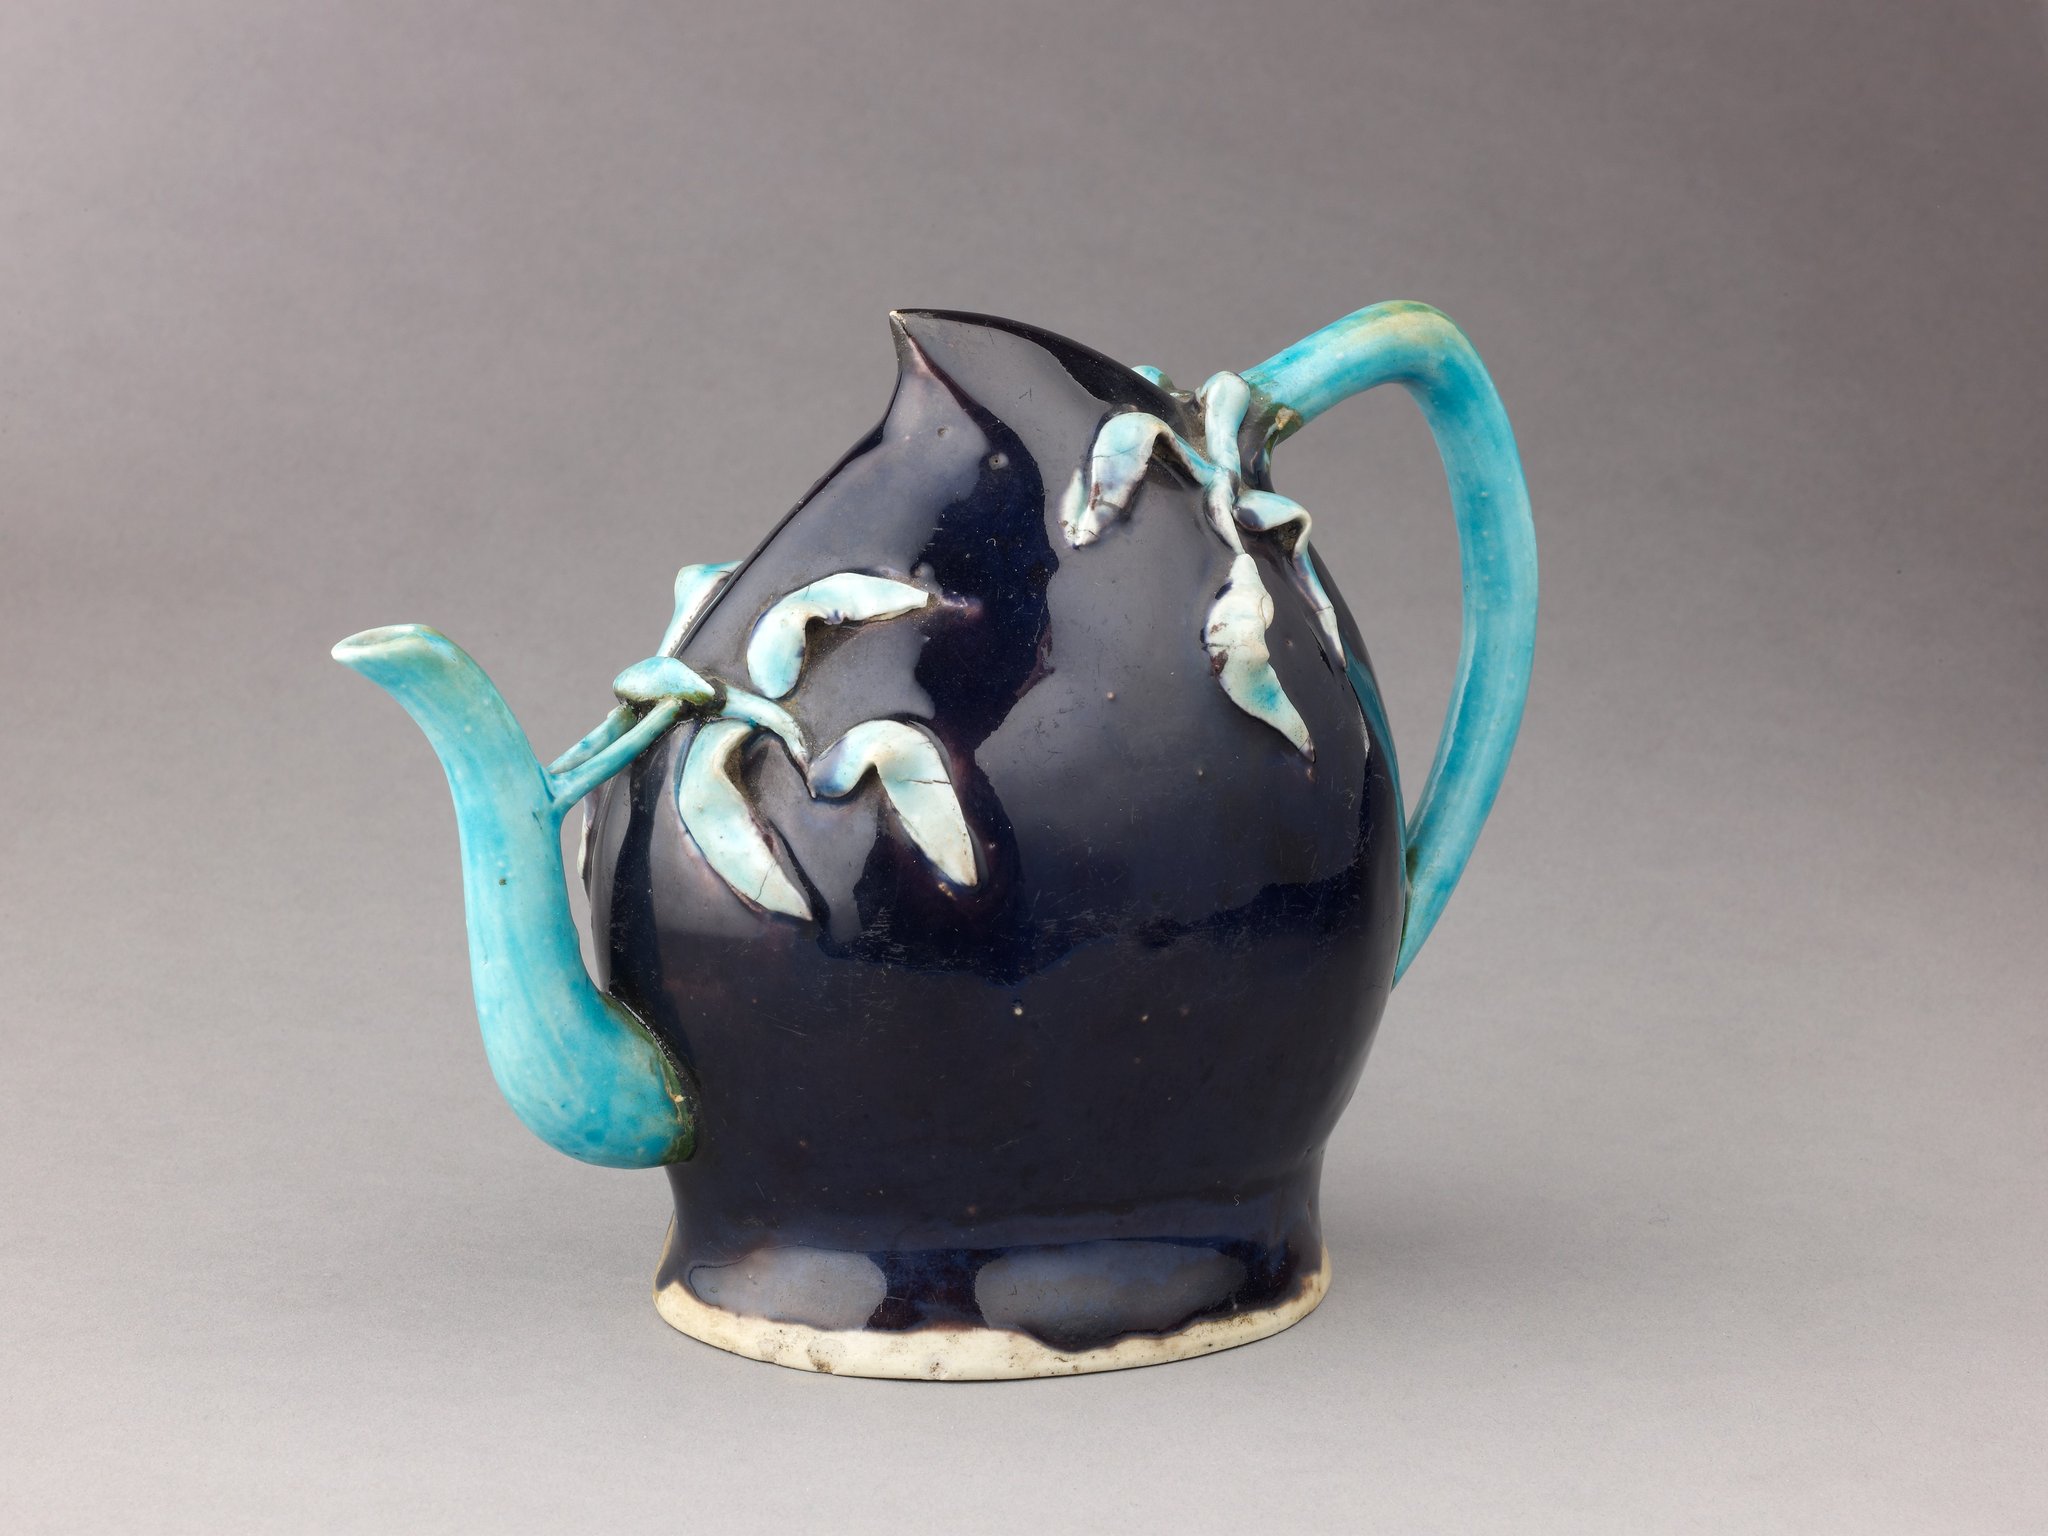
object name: winepot or teapot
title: Peach-shaped wine pot or teapot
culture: chinese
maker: chinese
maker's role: artist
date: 1667-1700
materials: glaze, porcelain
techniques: polychrome, relief